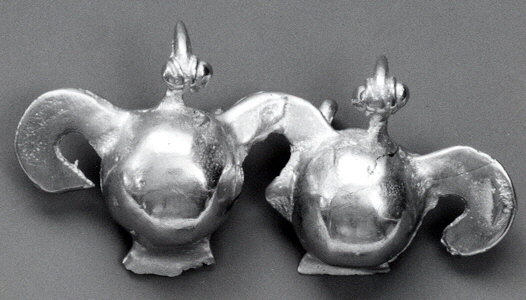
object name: pendant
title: Double Bird Pendant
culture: veraguas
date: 1001-1600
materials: gold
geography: panama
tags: birds